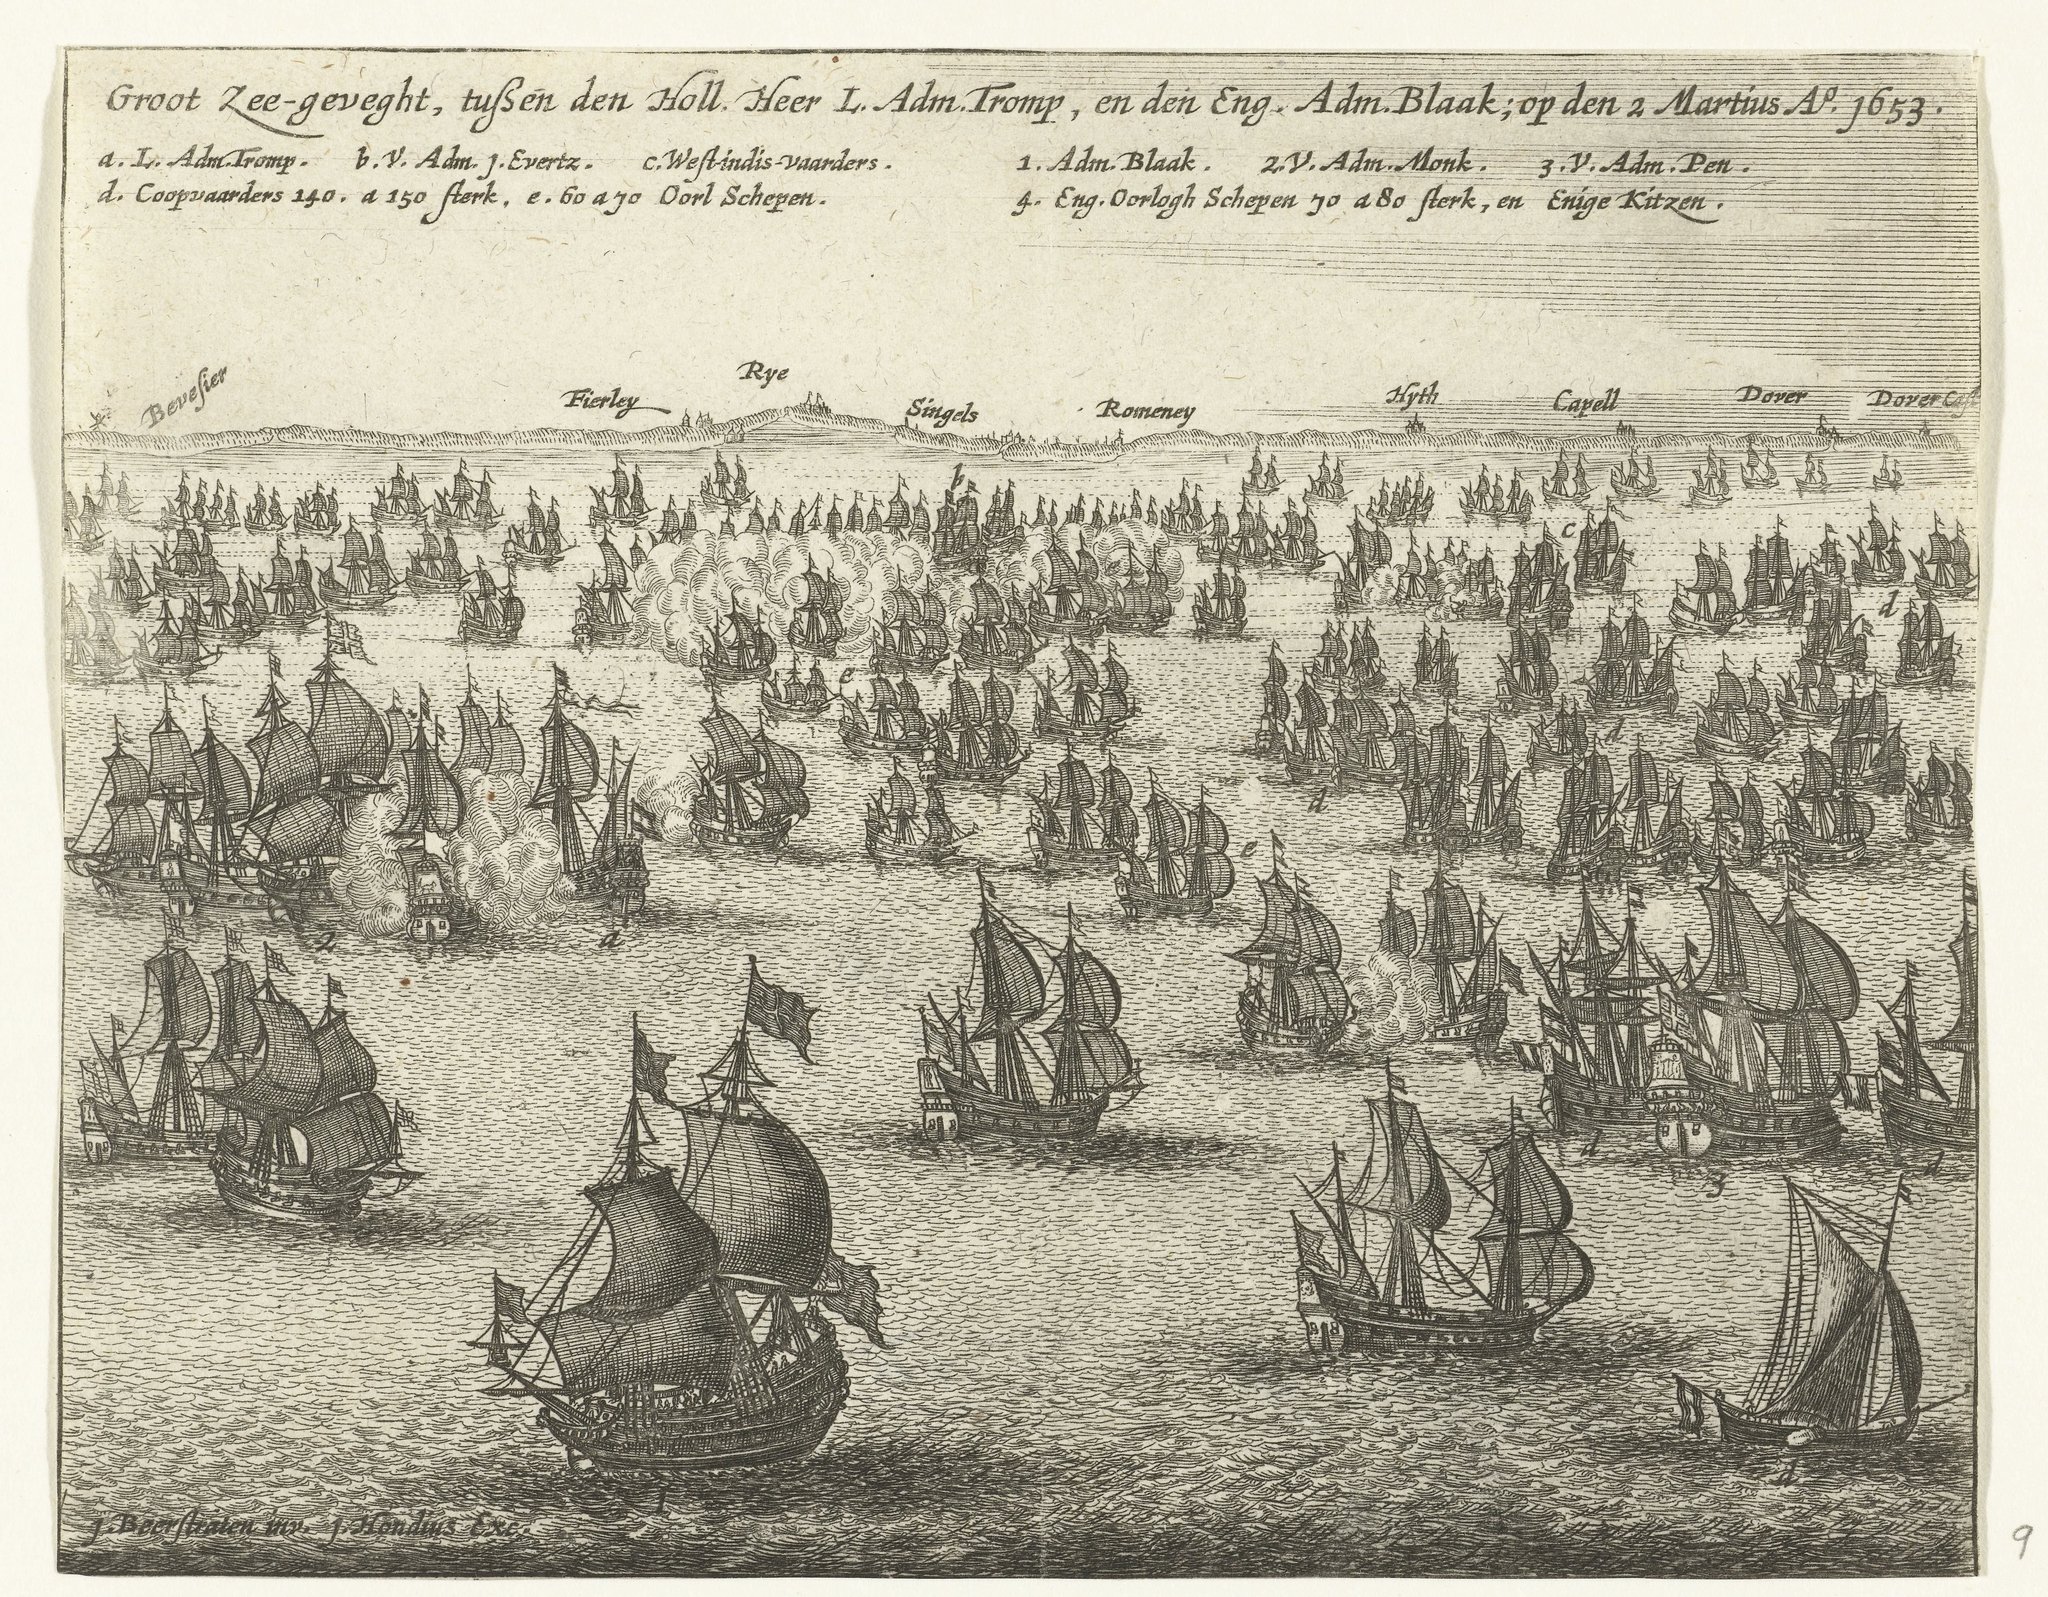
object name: print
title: Driedaagse Zeeslag tussen de Staatse vloot onder Tromp en de Engelse vloot onder Blake, 1653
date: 1654-1656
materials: paper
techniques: etching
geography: northern netherlands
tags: maarten harpertszoon tromp, battle (+ naval force), battle of portland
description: Driedaagse Zeeslag voor de Engelse zuidkust in de Eerste Engelse Oorlog tussen de Staatse vloot onder Maarten Tromp en de Engelse vloot onder Robert Blake, 2 maart 1653. Bovenaan de legenda a-e en 1-4. Ongenummerd [9].